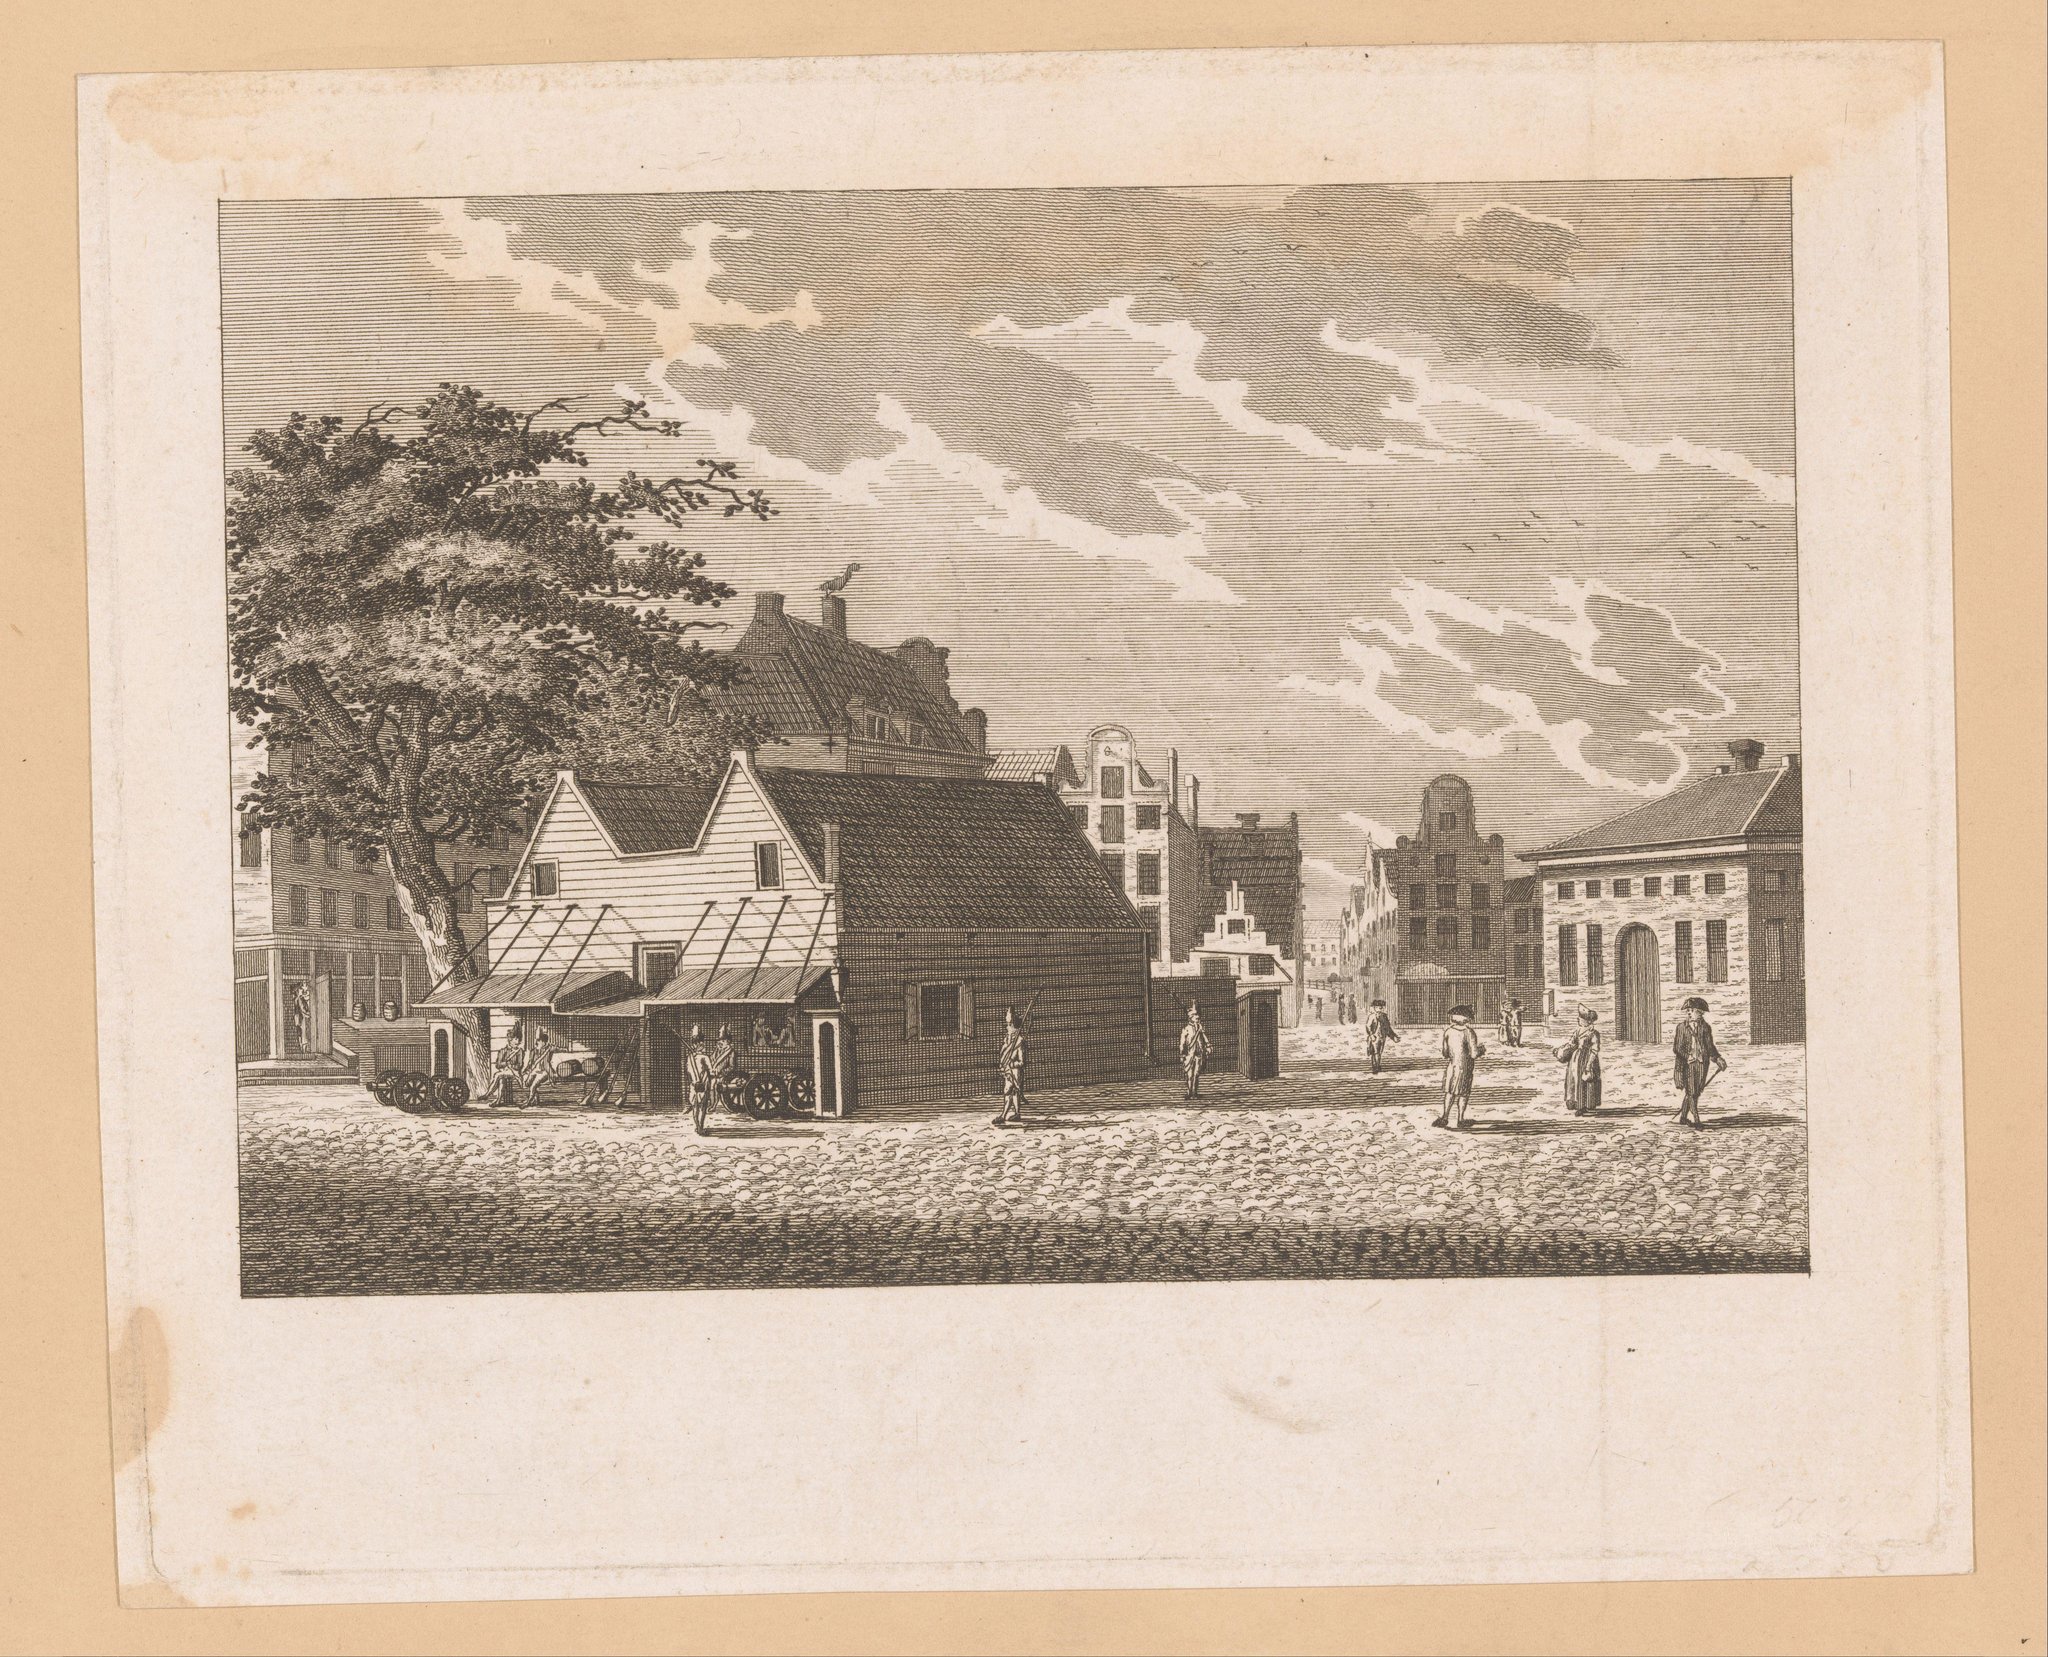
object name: print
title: Hoofdwacht van de landsmilitie op de Botermarkt in Amsterdam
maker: jacobus wijsman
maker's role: print maker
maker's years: 1768-1827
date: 1788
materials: paper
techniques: engraving, etching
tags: barracks (+ land forces), guard duty, keeping sentry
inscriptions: collector's mark: Lugt 2228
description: Gezicht op de hoofdwacht van de landsmilitie op het huidige Rembrandtplein.